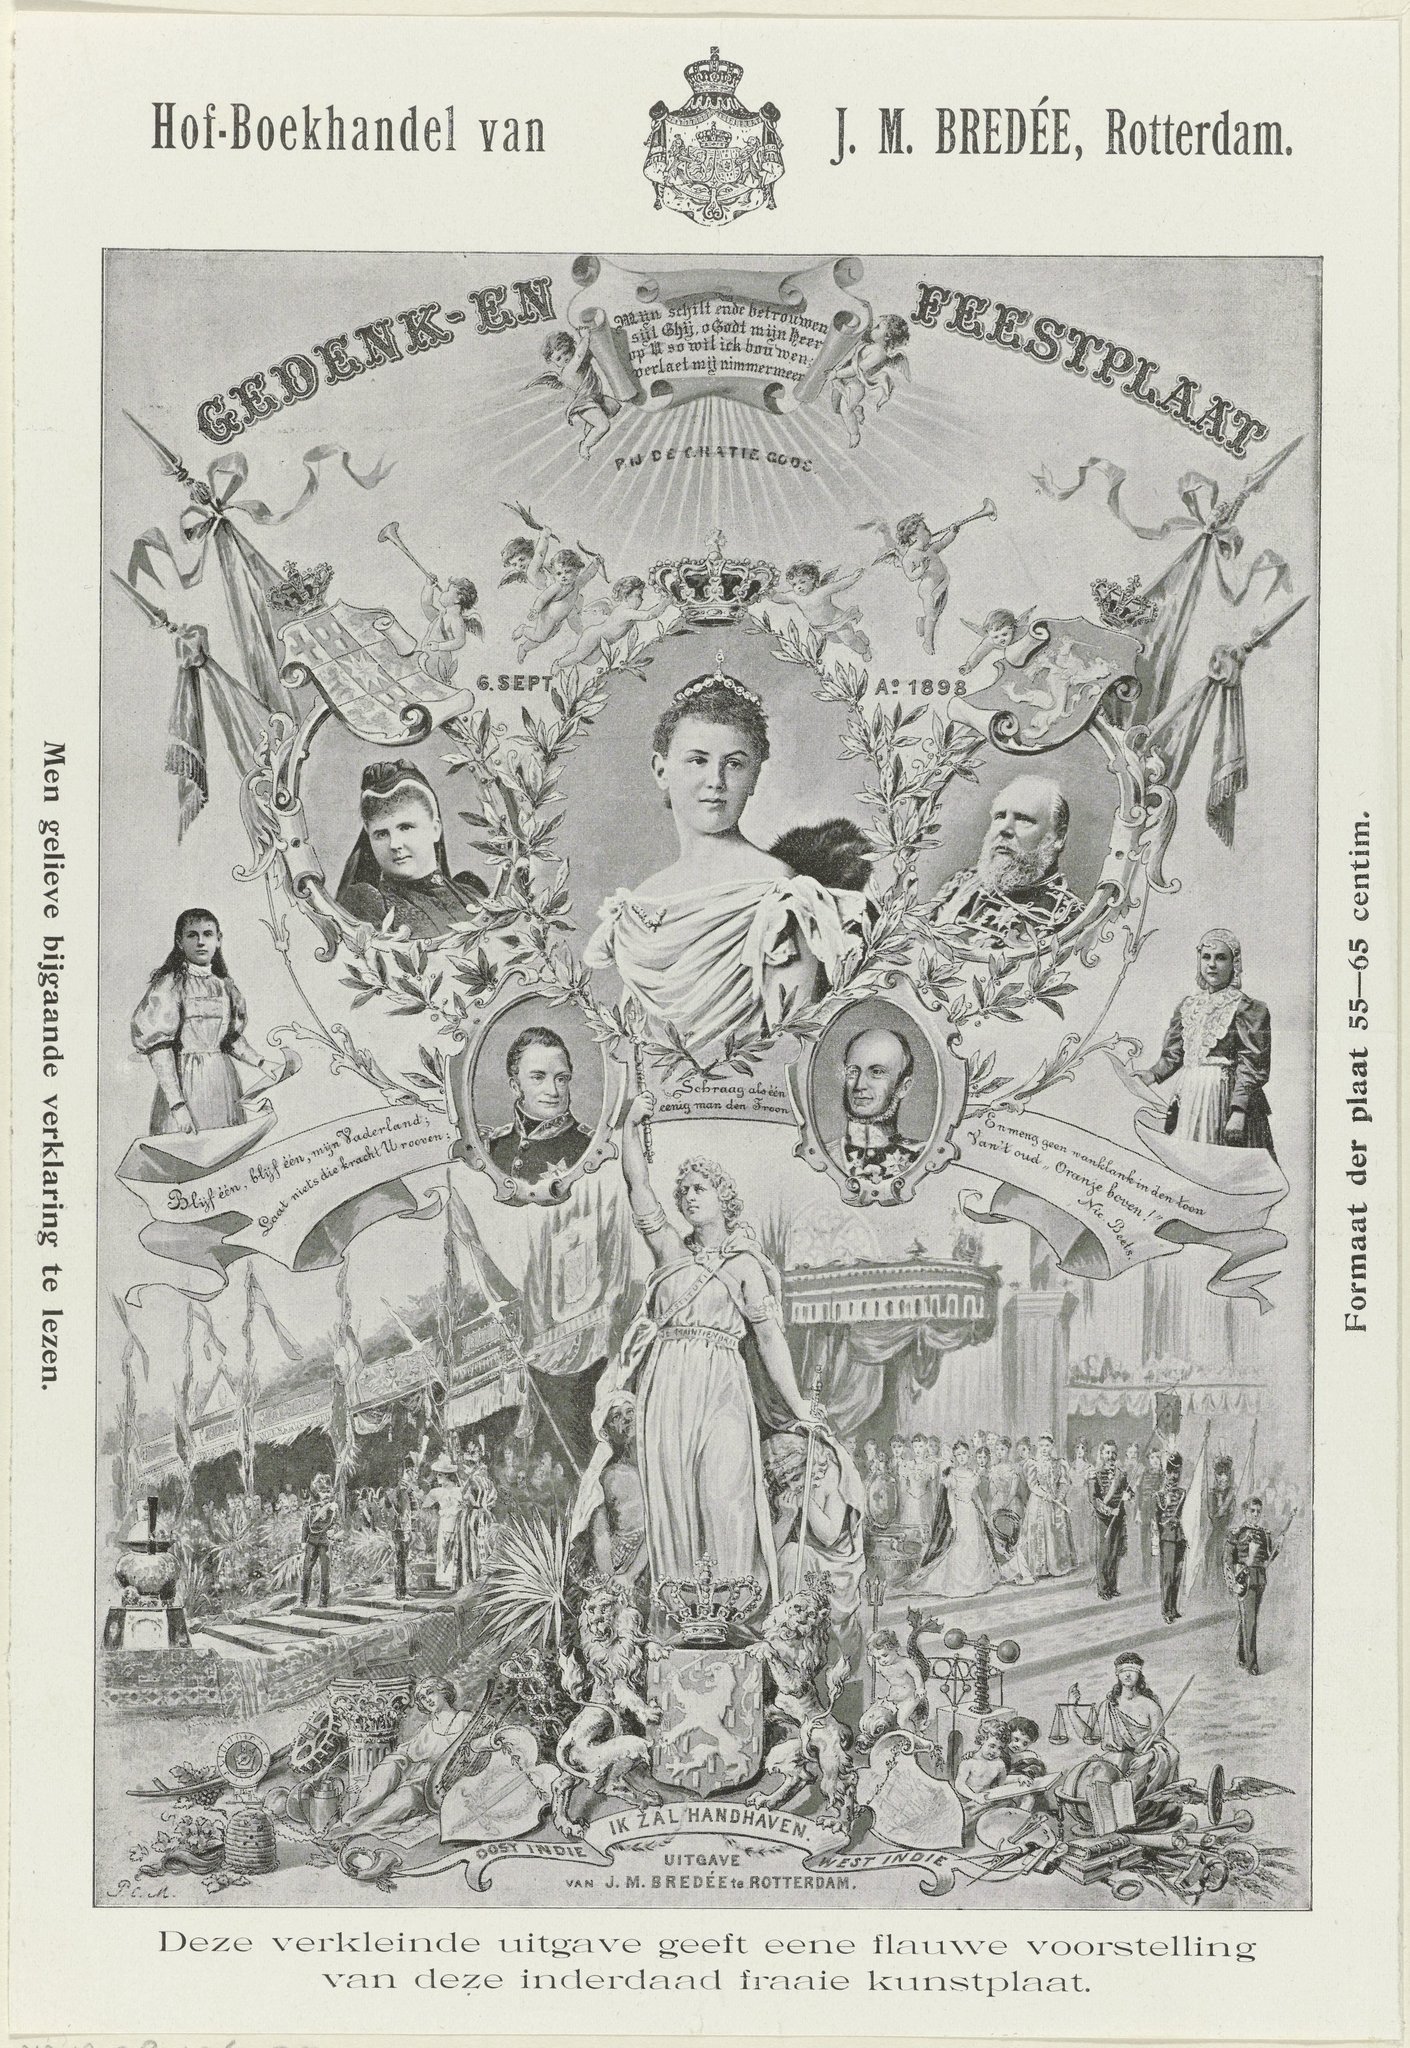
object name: photomechanical print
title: Gedenk- en feestplaat ter ere van de inhuldiging van Wilhelmina, koningin der Nederlanden, in de Nieuwe Kerk te Amsterdam op 6 september 1898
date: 1898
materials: paper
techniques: autotype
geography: rotterdam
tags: print maker, wilhelmina of the netherlands, emma (queen consort of the netherlands), berlin, william i of the netherlands, brussels, willem iii (koning der nederlanden), the hague, william ii of the netherlands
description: Gedenk- en feestplaat ter ere van de inhuldiging van Wilhelmina in de Nieuwe Kerk te Amsterdam op 6 september 1898. In het midden portretten van Wilhelmina, Willem I Frederik, Willem II, Willem III en Emma. Daaronder de inhuldiging van Wilhelmina. Daar omheen meerdere allegorische objecten en figuren. In de marges regels Nederlandse tekst.